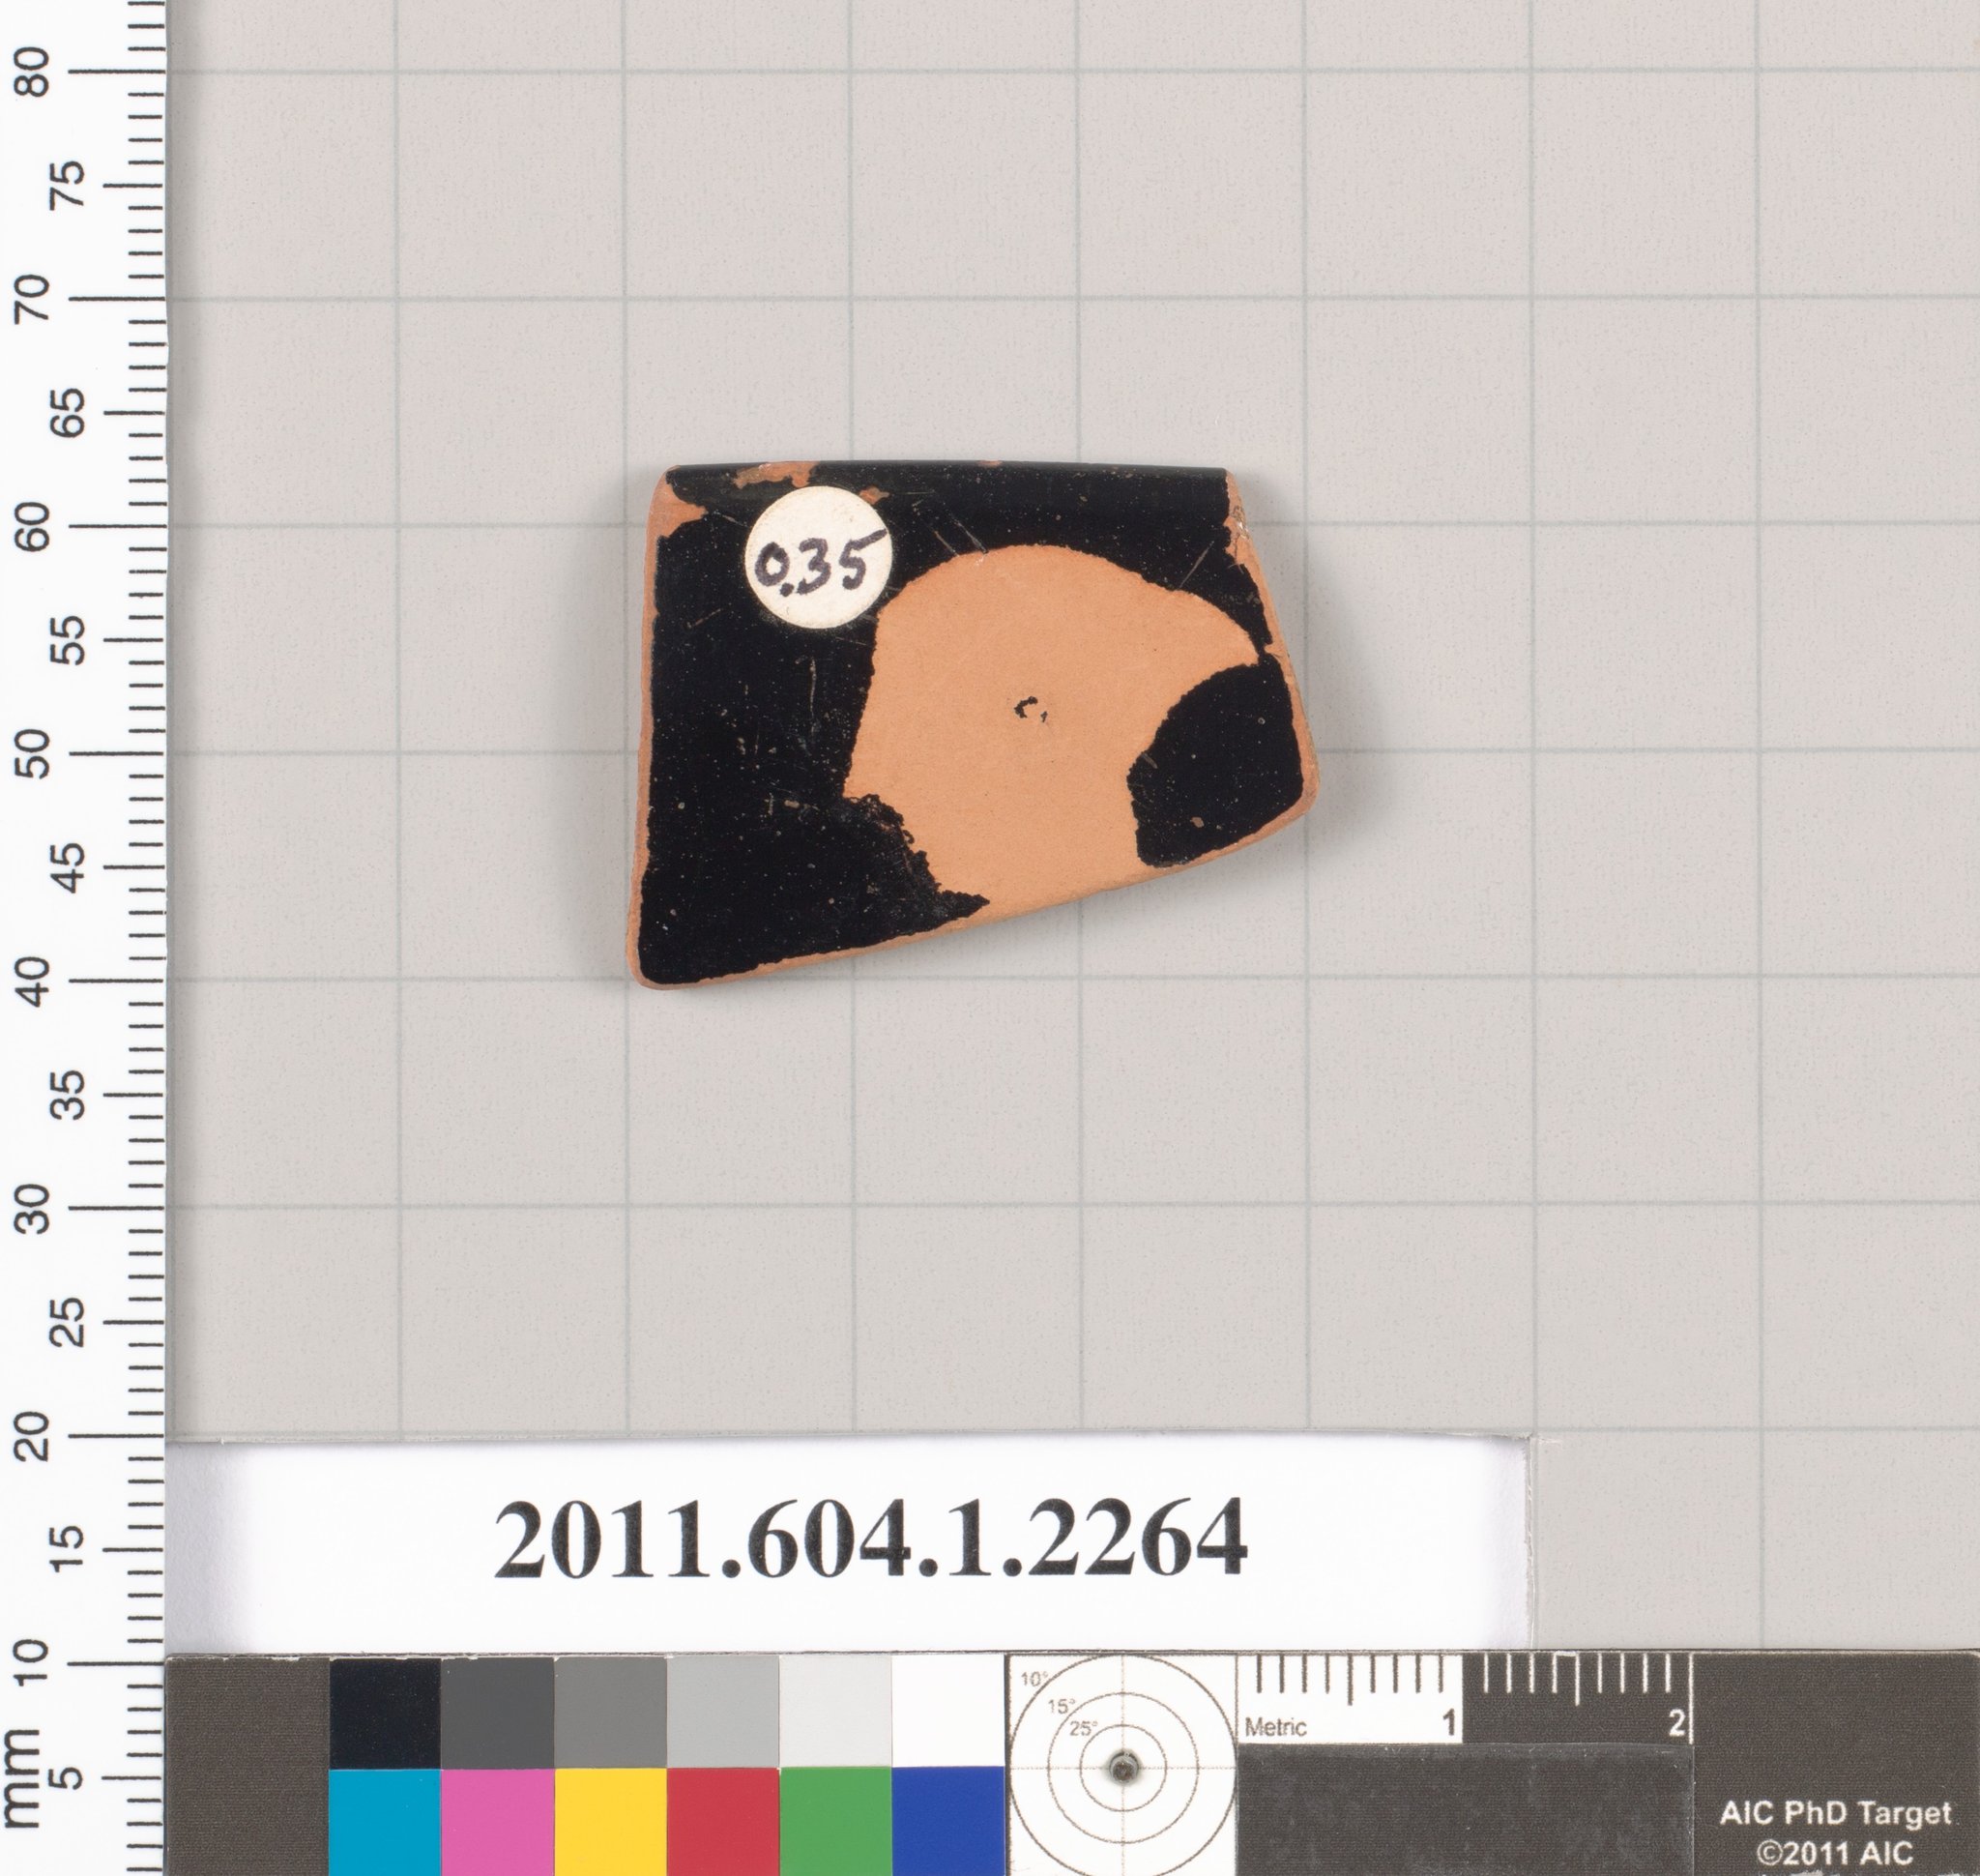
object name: kylix fragment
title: Terracotta rim fragment of a kylix (drinking cup)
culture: greek, attic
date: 467-435 BCE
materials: terracotta